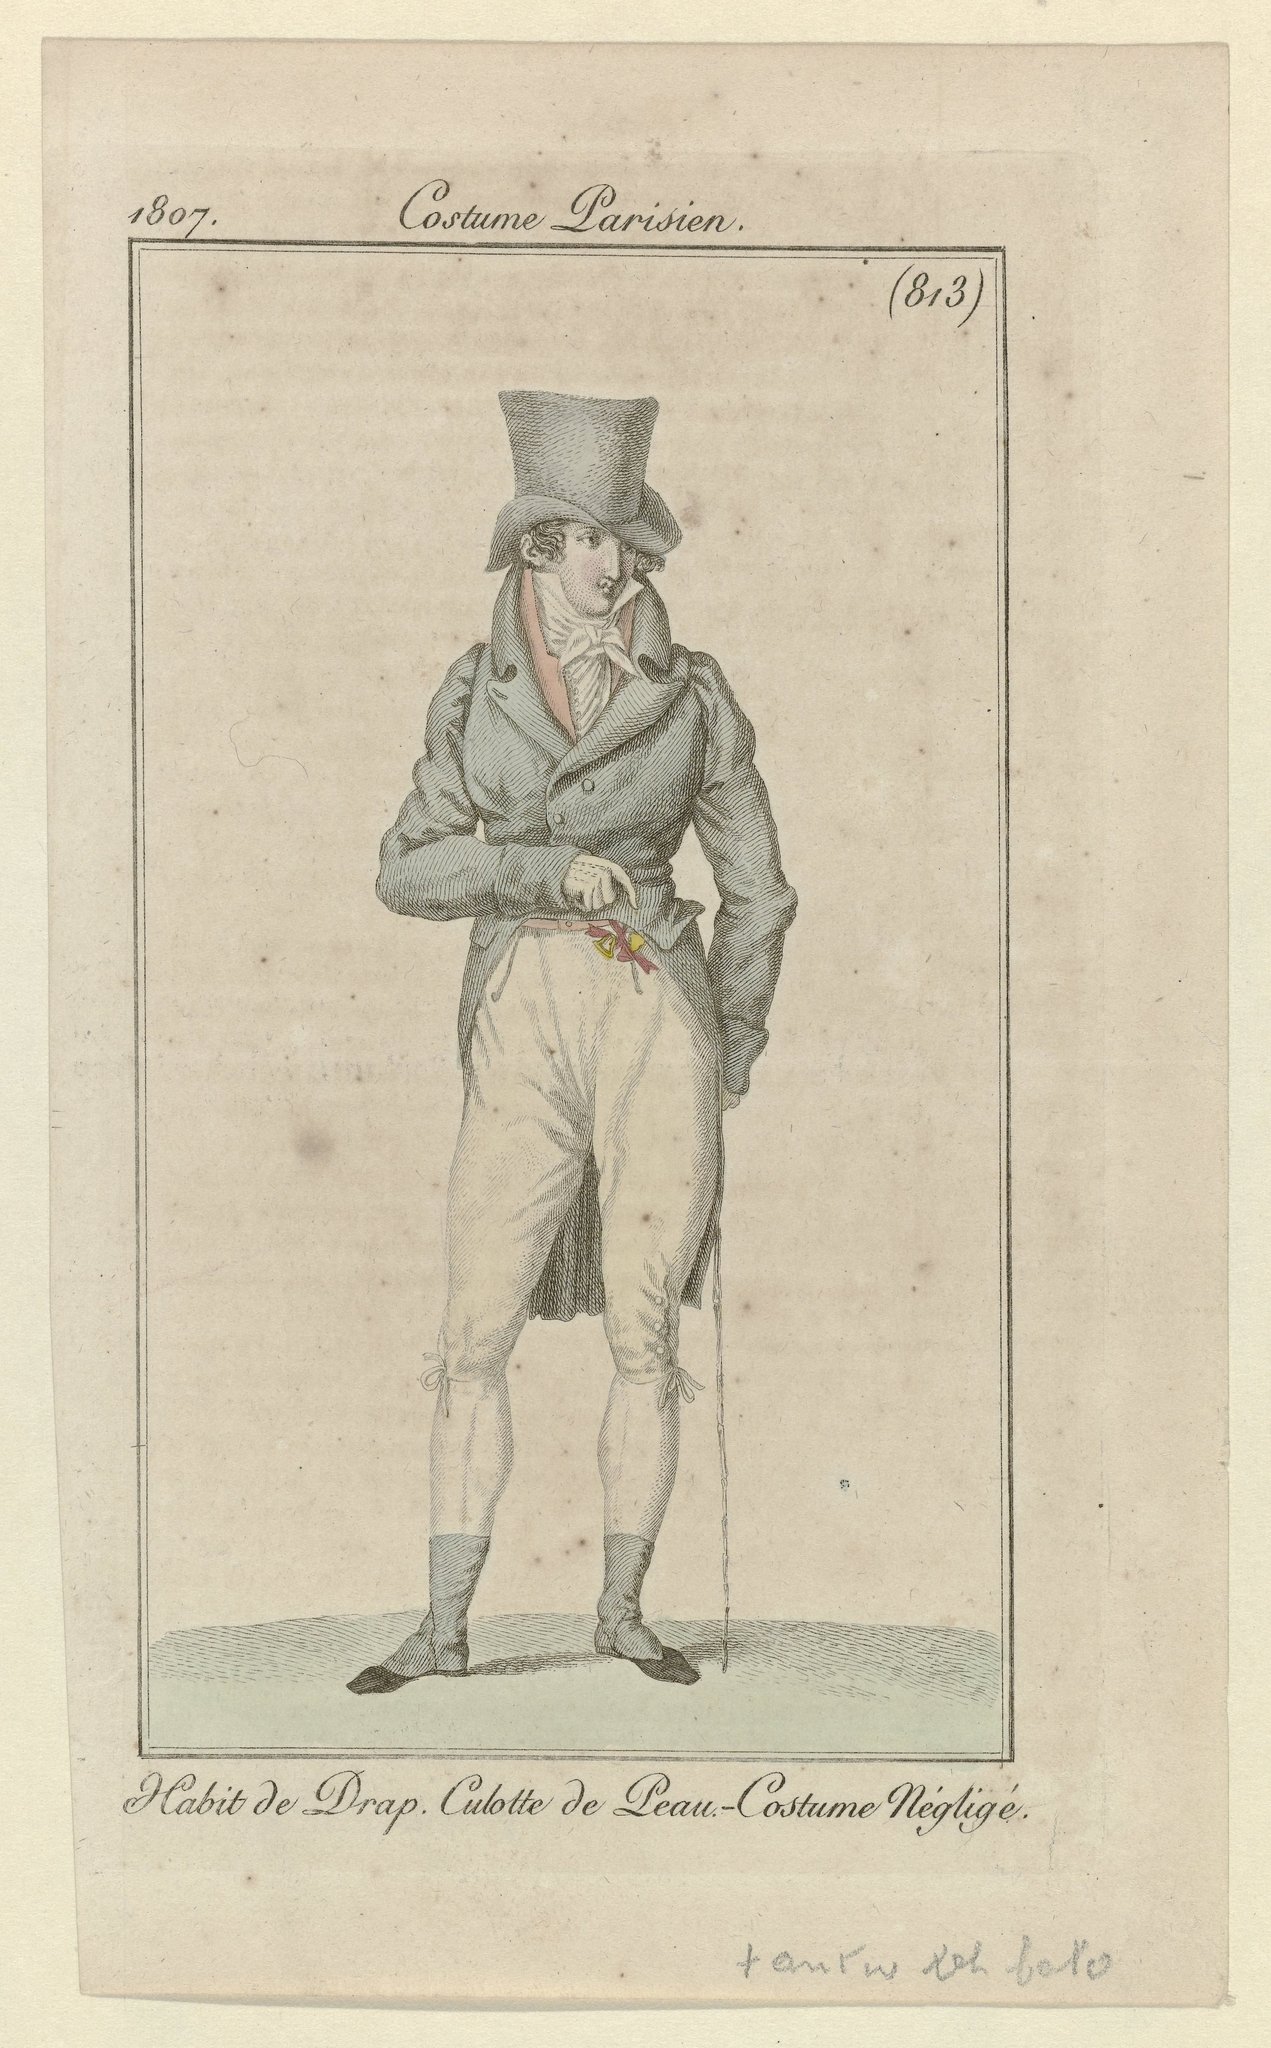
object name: fashion print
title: Journal des Dames et des Modes, Costume Parisien, 10 juin 1807, (813): Habit de Drap (...)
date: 1807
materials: paper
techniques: engraving, hand coloring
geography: paris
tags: clothing for the upper part of the body (vest) (+ men's clothes), neck-gear ~ clothing (cravat) (+ men's clothes), coat (+ men's clothes), fashion plates, shoes, sandals (+ men's clothes), trousers, breeches, etc. (breeches) (+ men's clothes), walking-stick, staff, cane (+ men's clothes)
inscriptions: title: ‘Costume Parisien.’, caption: ‘Habit de Drap. Culotte de Peau.-Costume Négligé.’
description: Staande man gekleed in een 'Costume Négligé'. Hij draagt een 'habit' van laken, een vest en een kniebroek van leer. Hemd en cravate. Kousen en slobkousen. Accessoires: hoge hoed, handschoenen, wandelstok, schoenen met vierkante neuzen. De prent maakt deel uit van het modetijdschrift Journal des Dames et des Modes, uitgegeven door Pierre de la Mésangère, Parijs, 1797-1839.